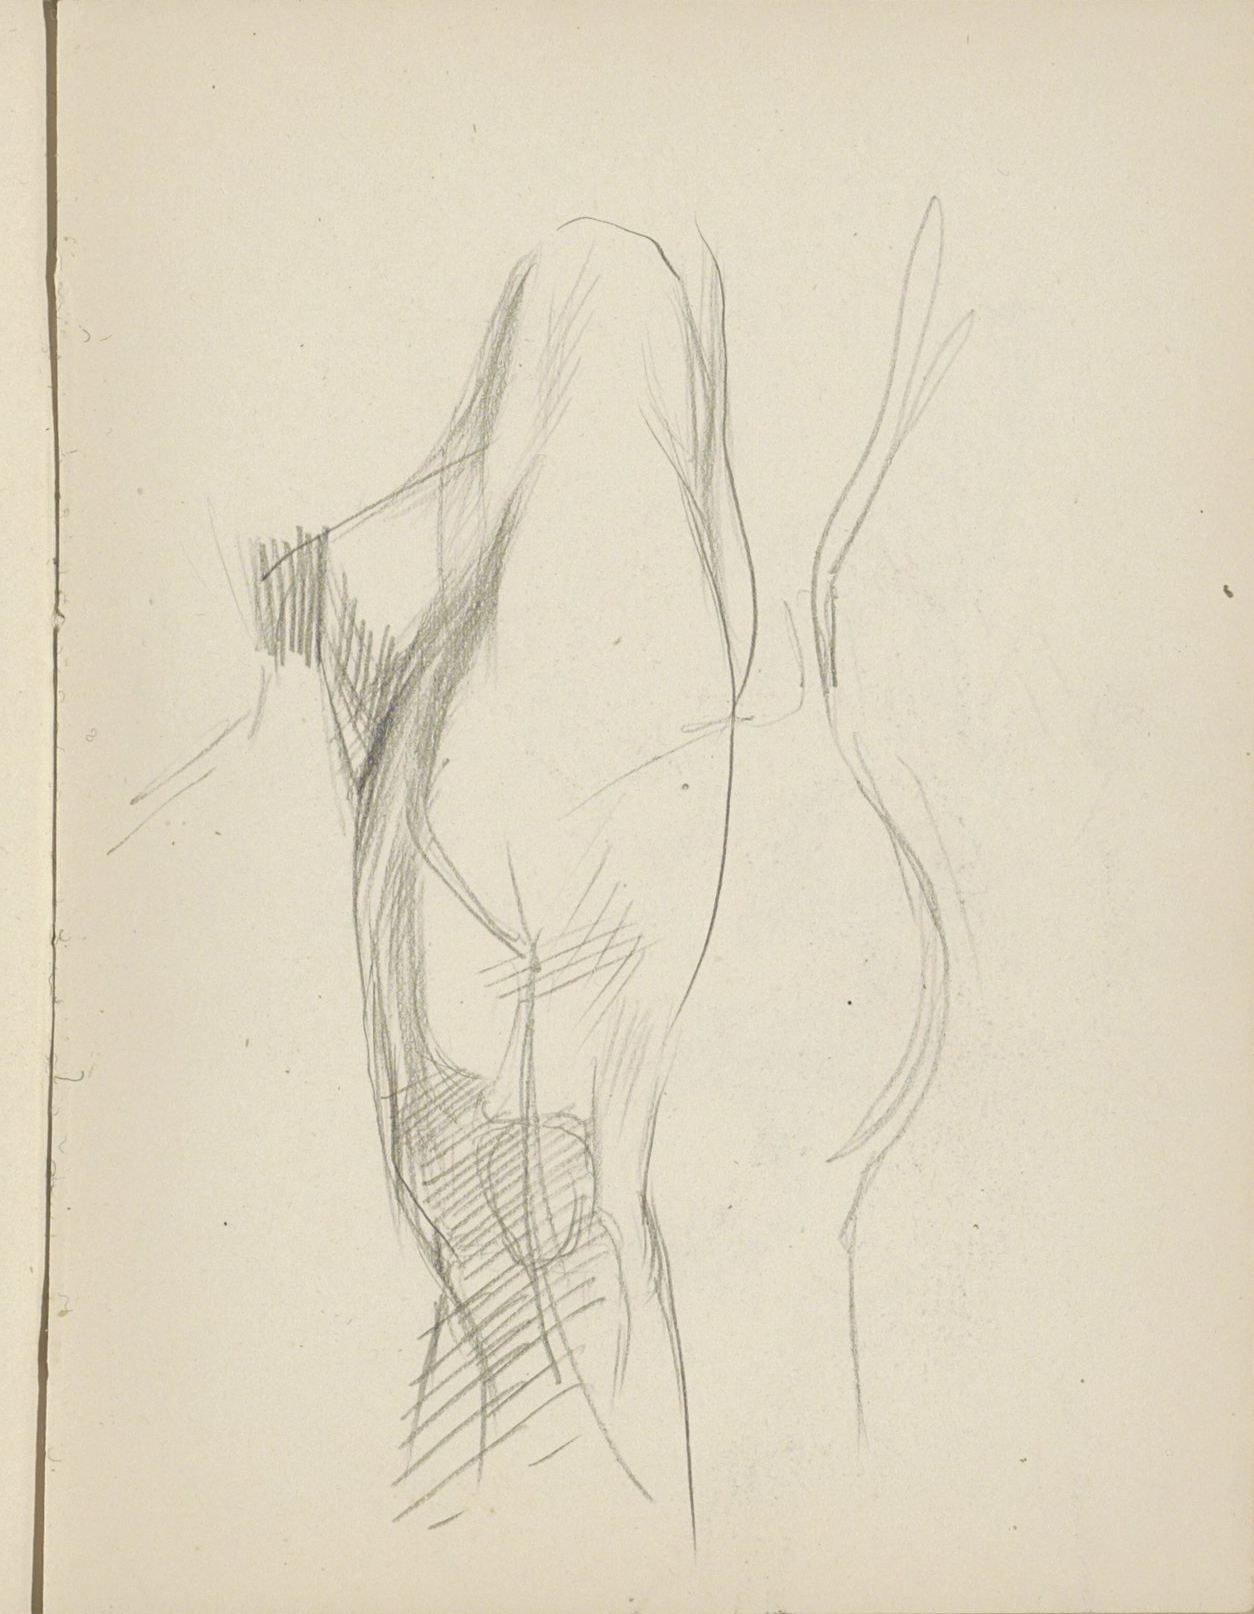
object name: sketchbook leaf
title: Bovenbeen en een rug in profiel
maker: reijer stolk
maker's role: draughtsman, print maker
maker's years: 1896-1945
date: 1906-1945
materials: paper, pencil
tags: upper leg, back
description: Blad 67 recto uit een schetsboek met 69 bladen.